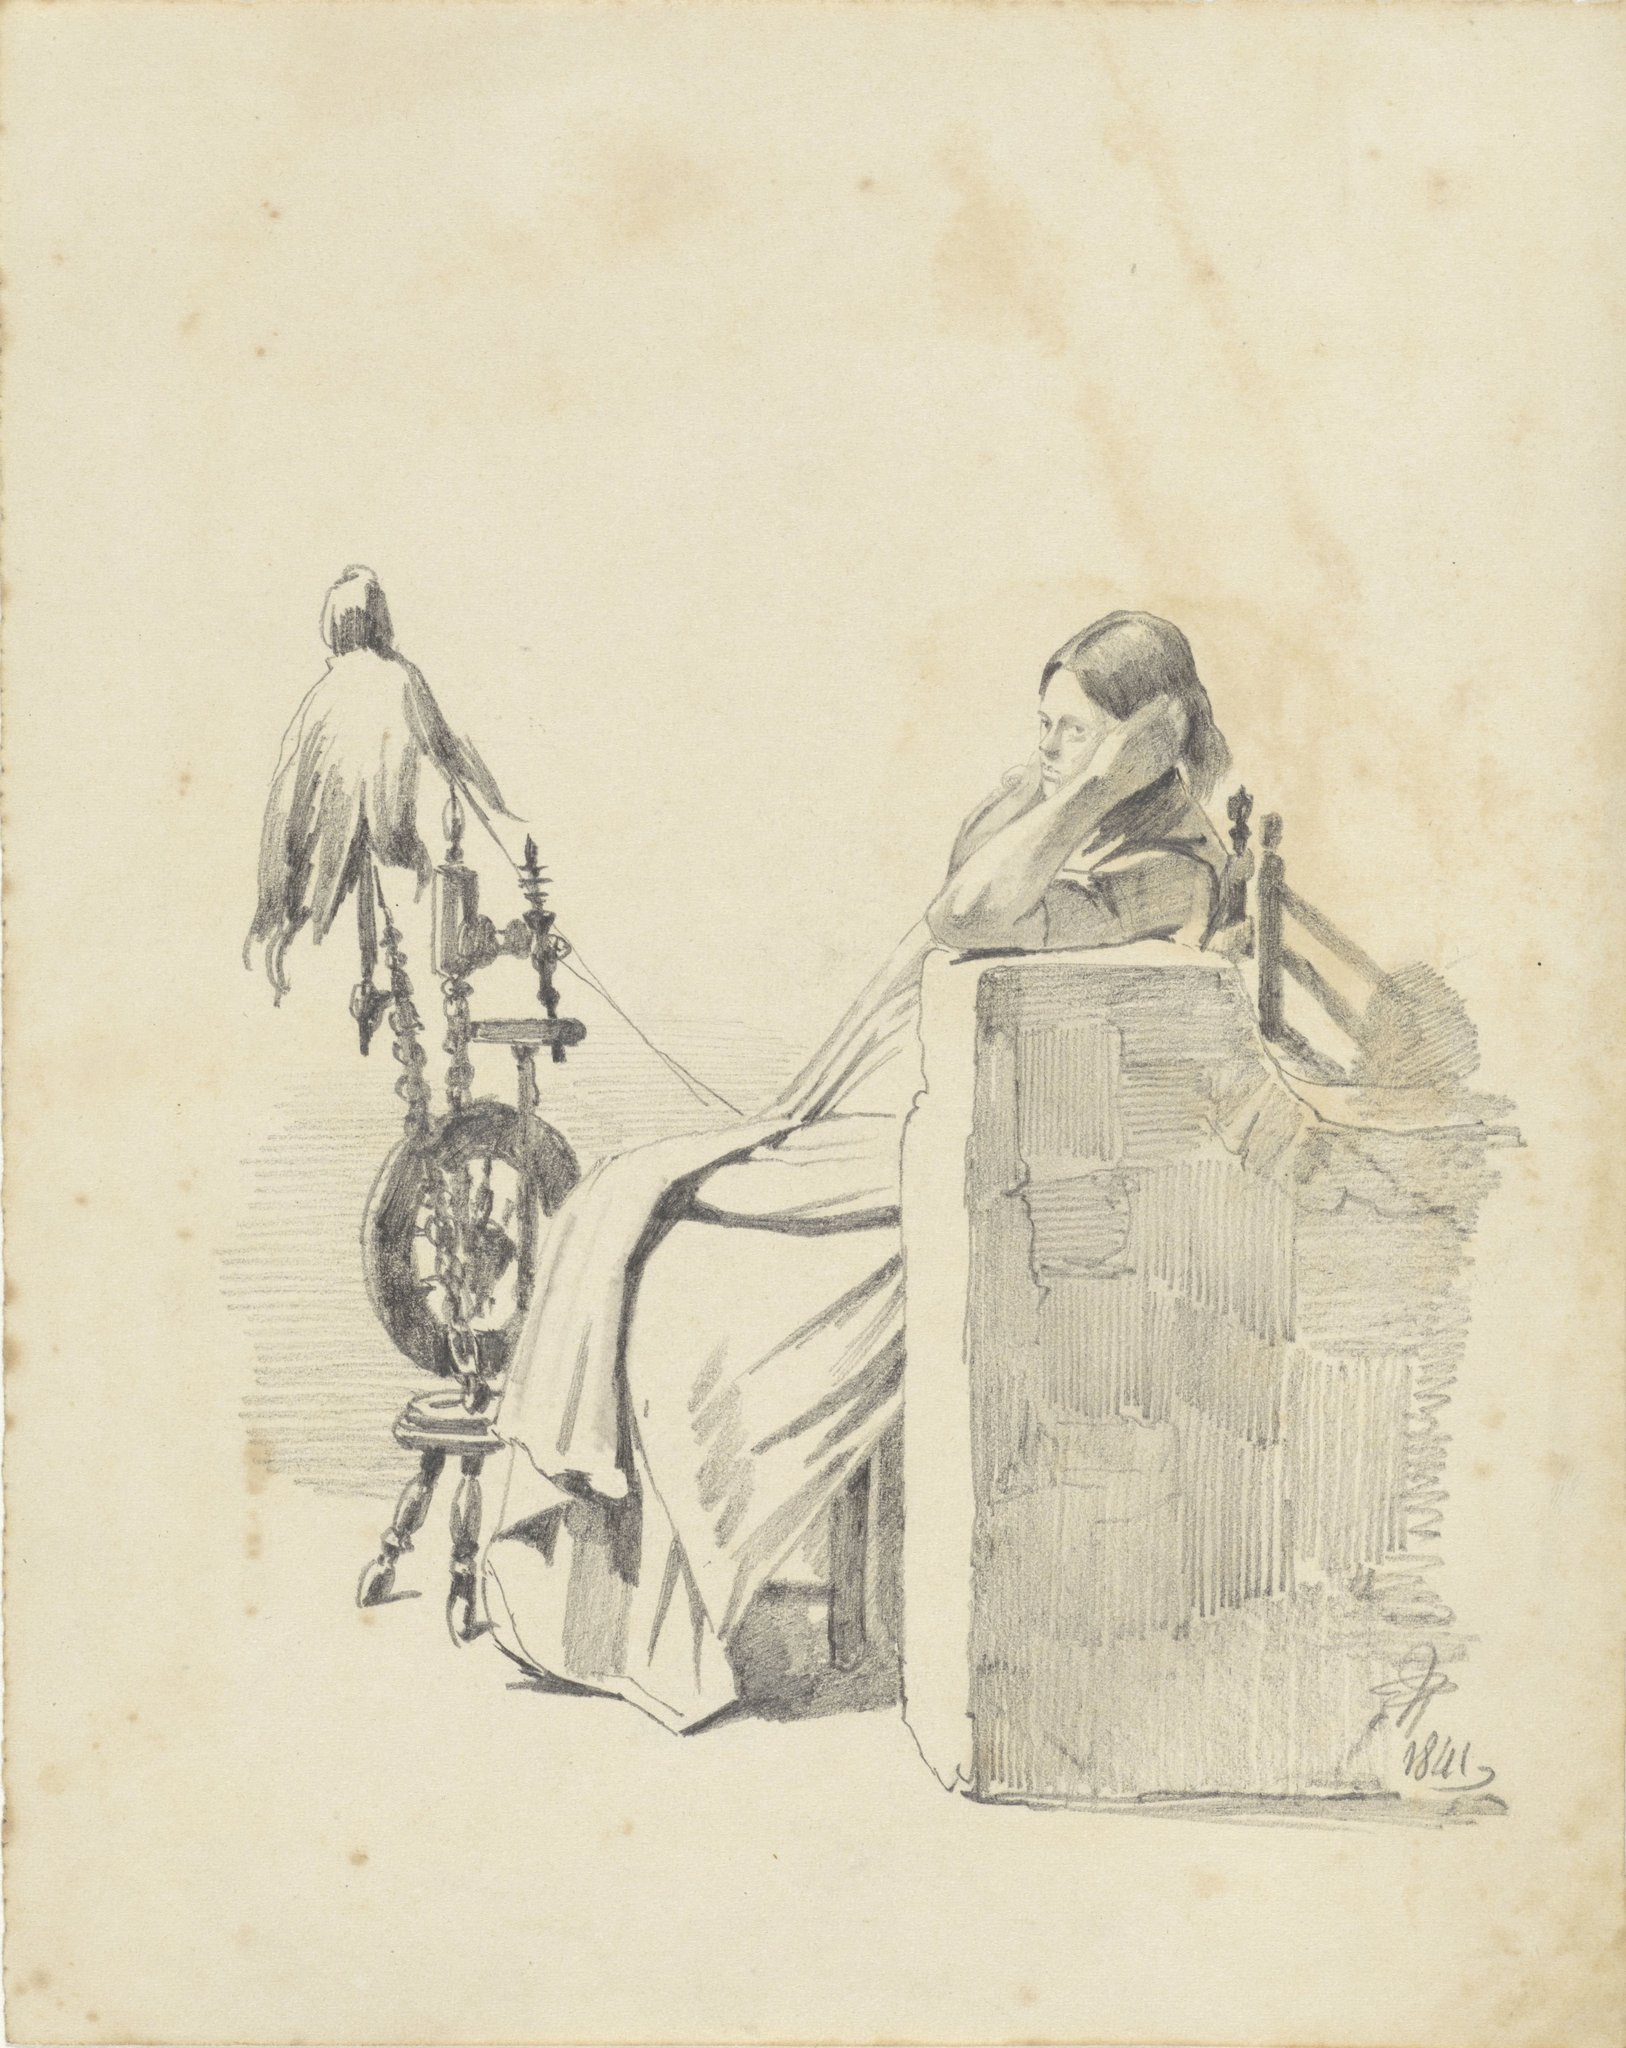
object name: drawing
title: Zittende spinster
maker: pieter van loon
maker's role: draughtsman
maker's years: 1801-1873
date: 1841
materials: paper, pencil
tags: spinning (manufacture of yarn)